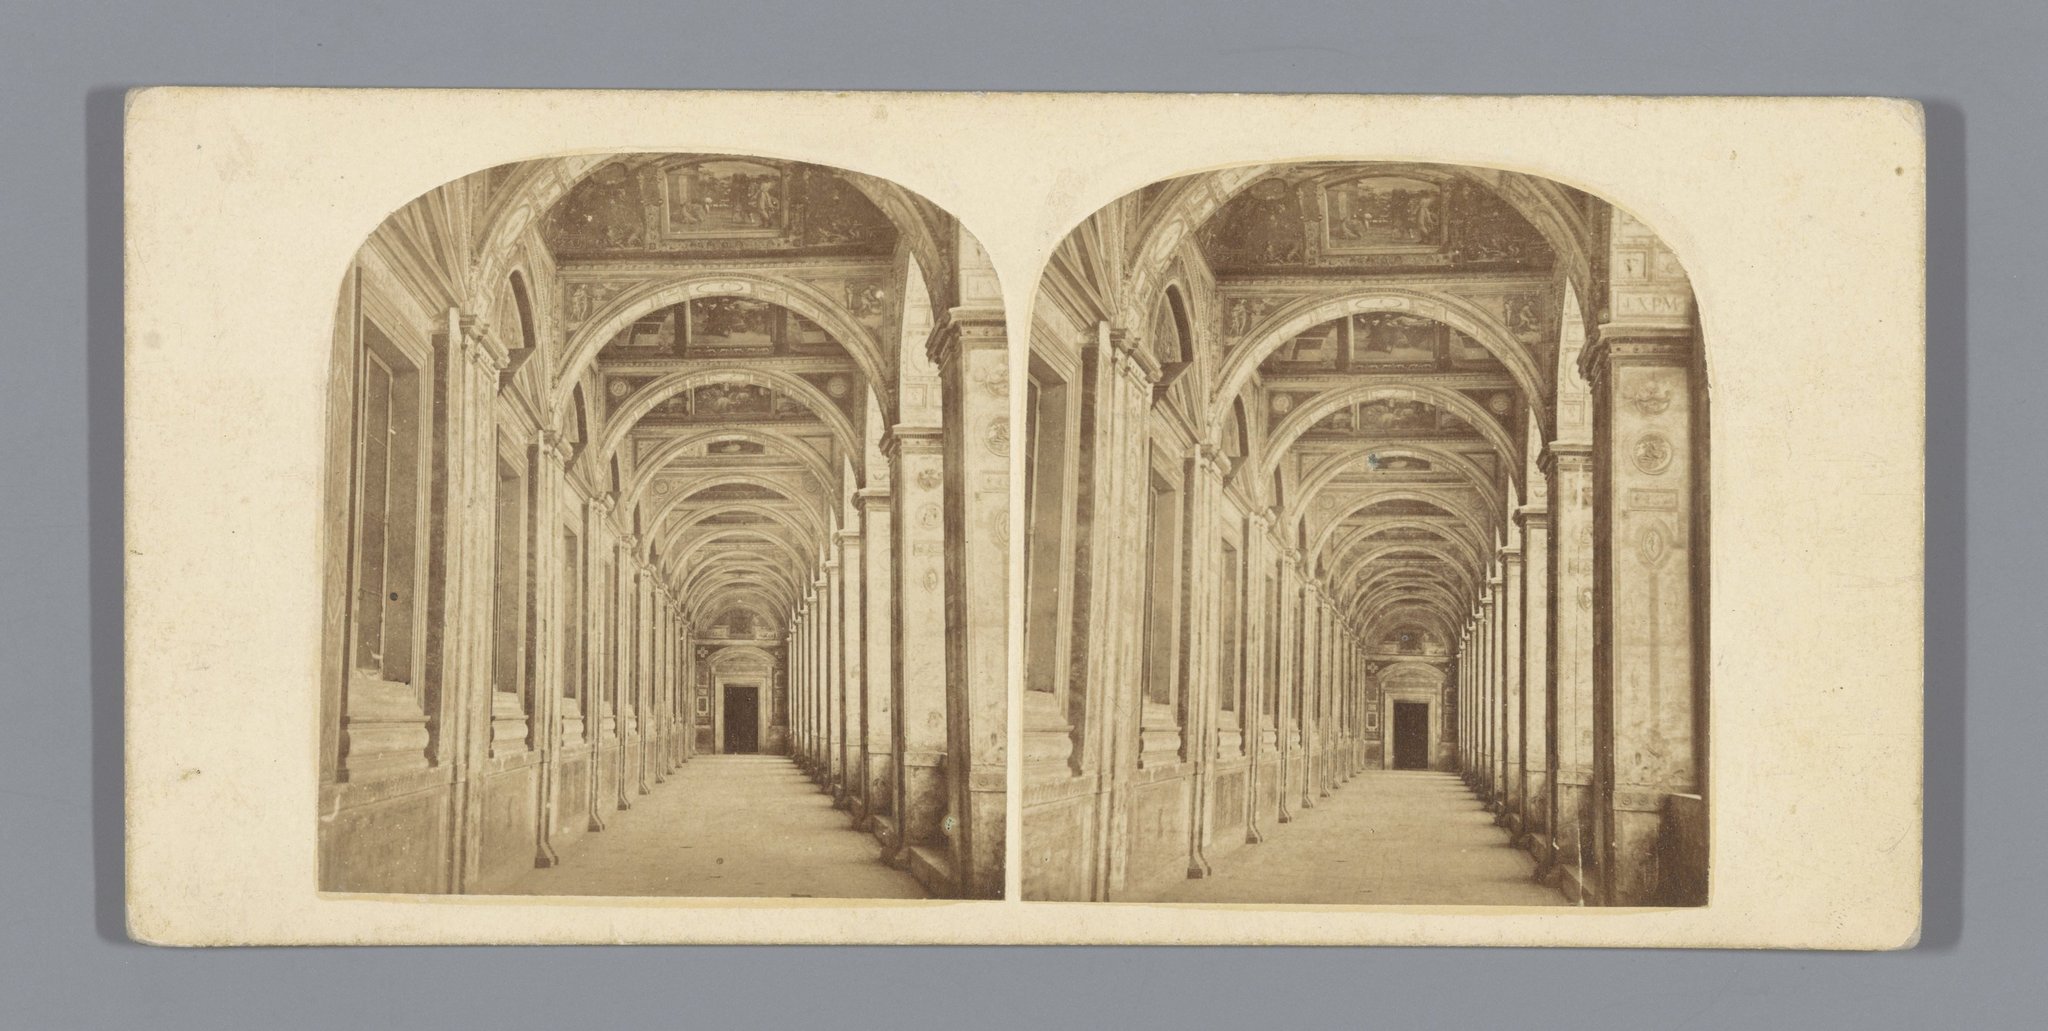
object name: stereograph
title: Loggia di Raffaello in het Apostolisch Paleis te Vaticaanstad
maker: Anonymous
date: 1850-1880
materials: cardboard, photographic support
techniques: albumen print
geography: apostolisch paleis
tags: corridor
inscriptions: inscription: ‘Les Loges de Raphaël Vatican’, number: ‘No 65’